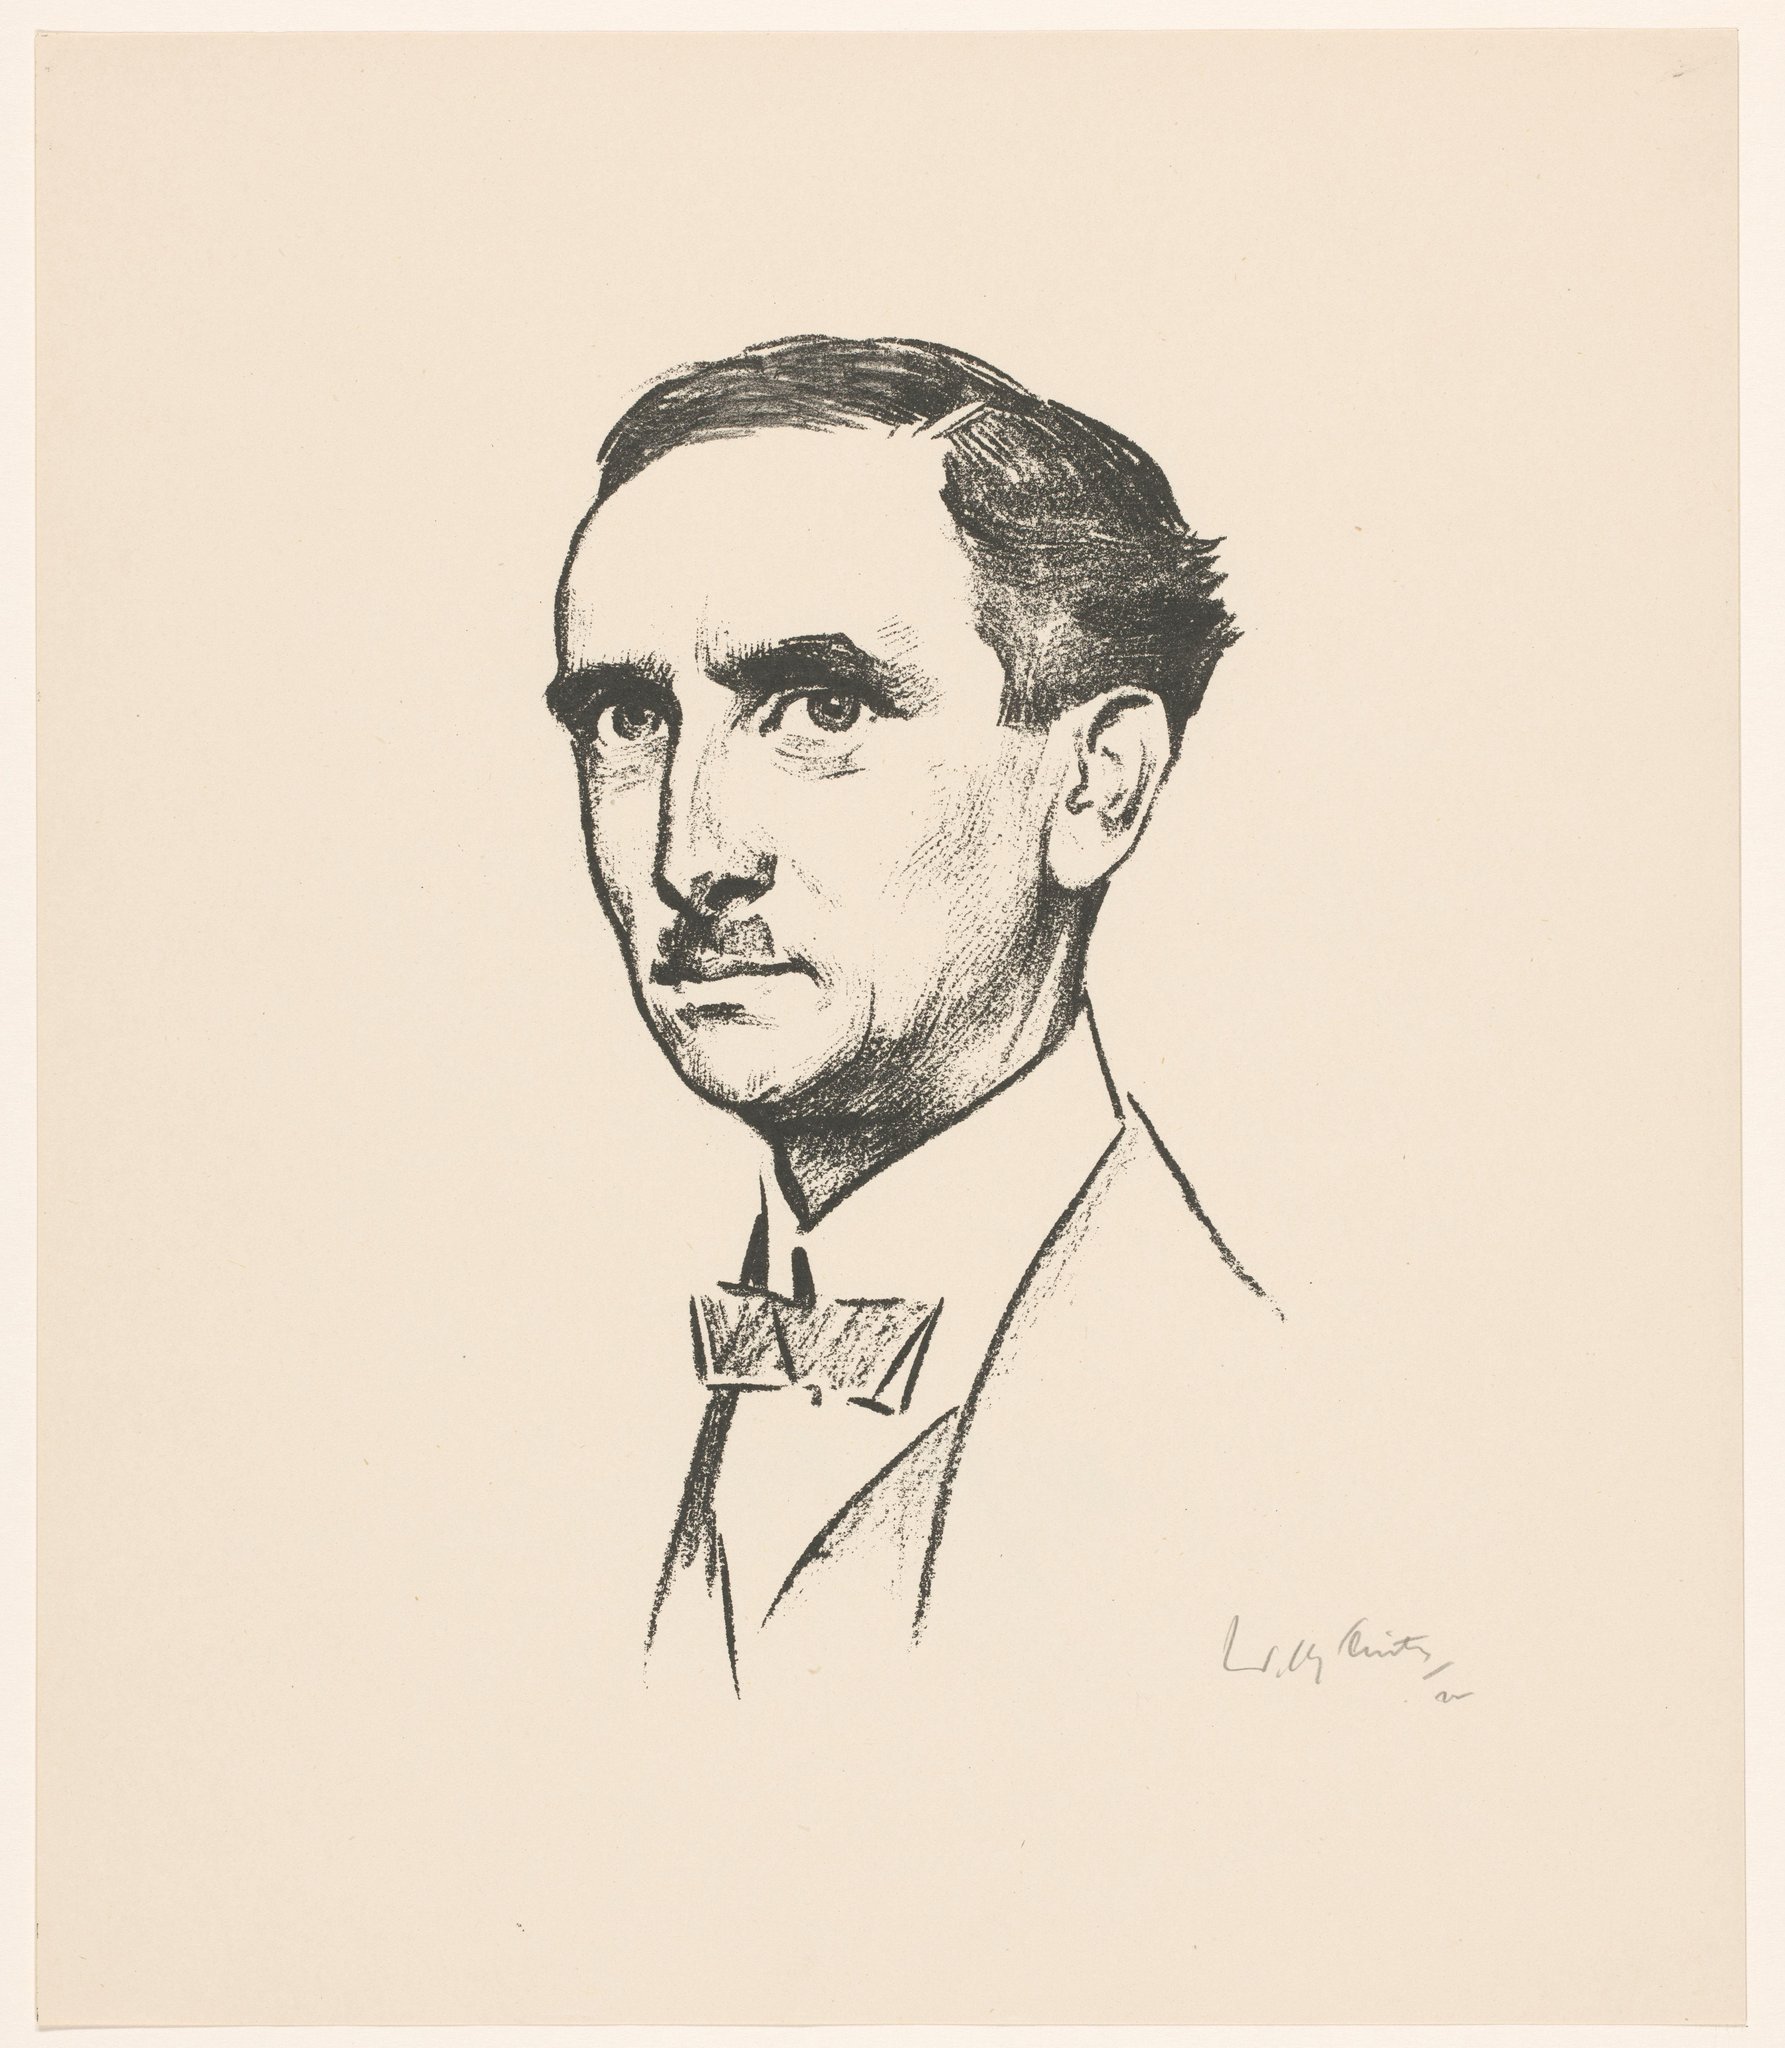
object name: print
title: Portret van Jean François van Royen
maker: willy sluiter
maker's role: draughtsman, painter, print maker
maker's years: 1873-1949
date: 1922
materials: paper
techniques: lithograph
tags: arnhem, printer, historical persons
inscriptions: collector's mark: Lugt 2228